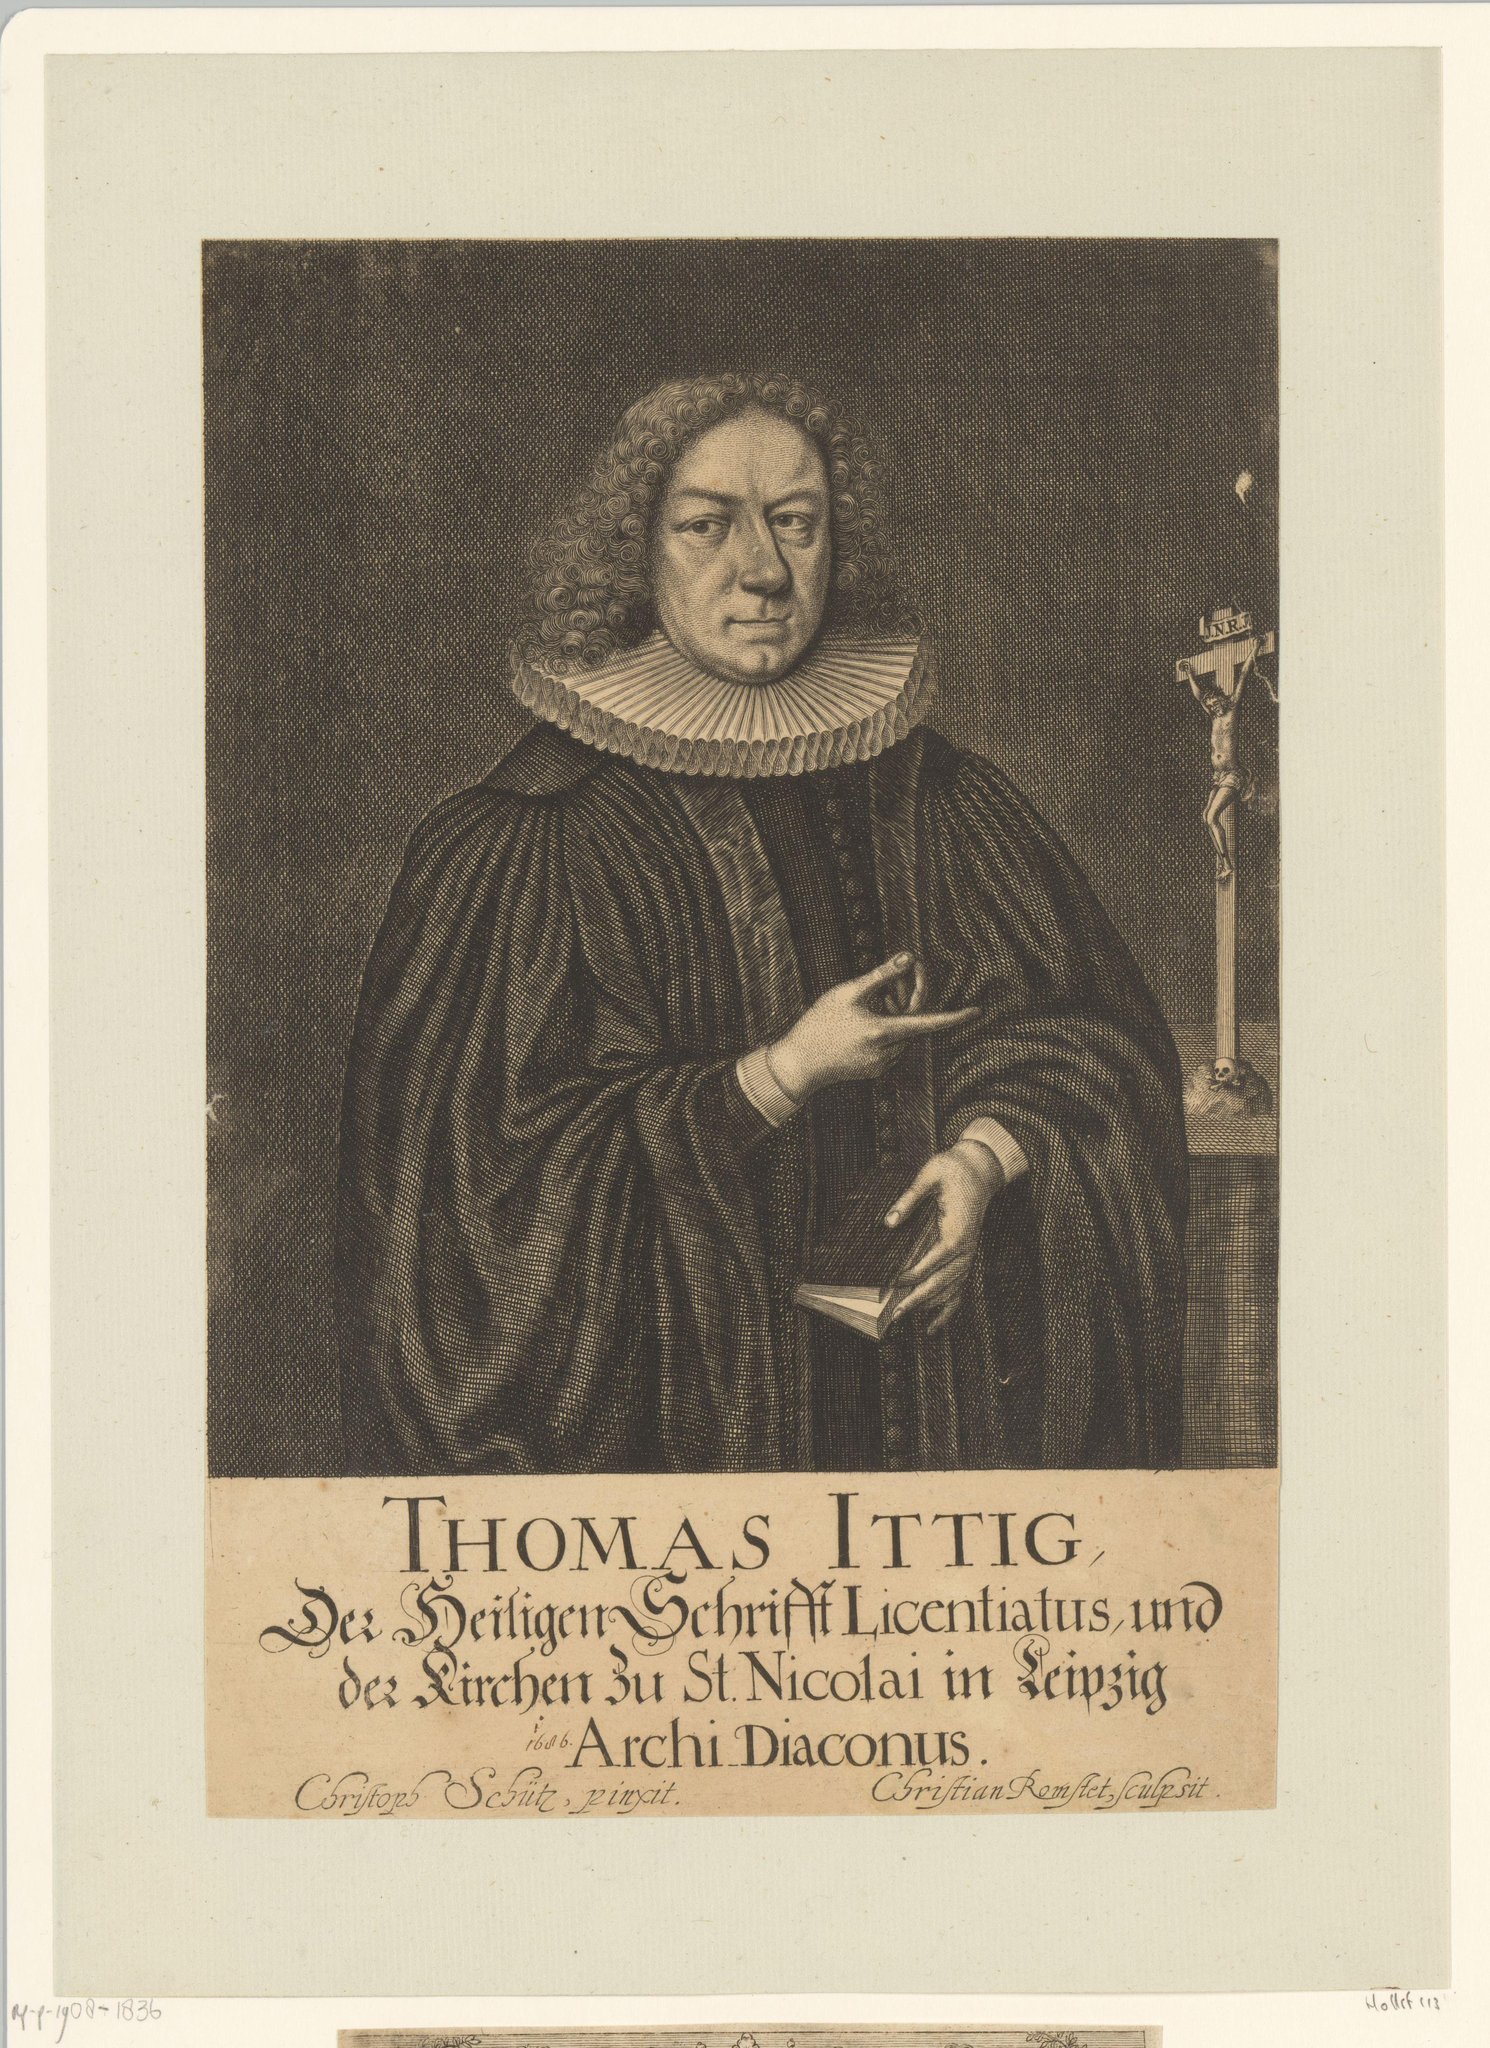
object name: print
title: Portret van Thomas Ittig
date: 1665-1721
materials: paper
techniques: engraving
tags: thomas ittig, theologian, historical persons, book, crucifix ~ personal devotion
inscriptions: collector's mark: Lugt 2228